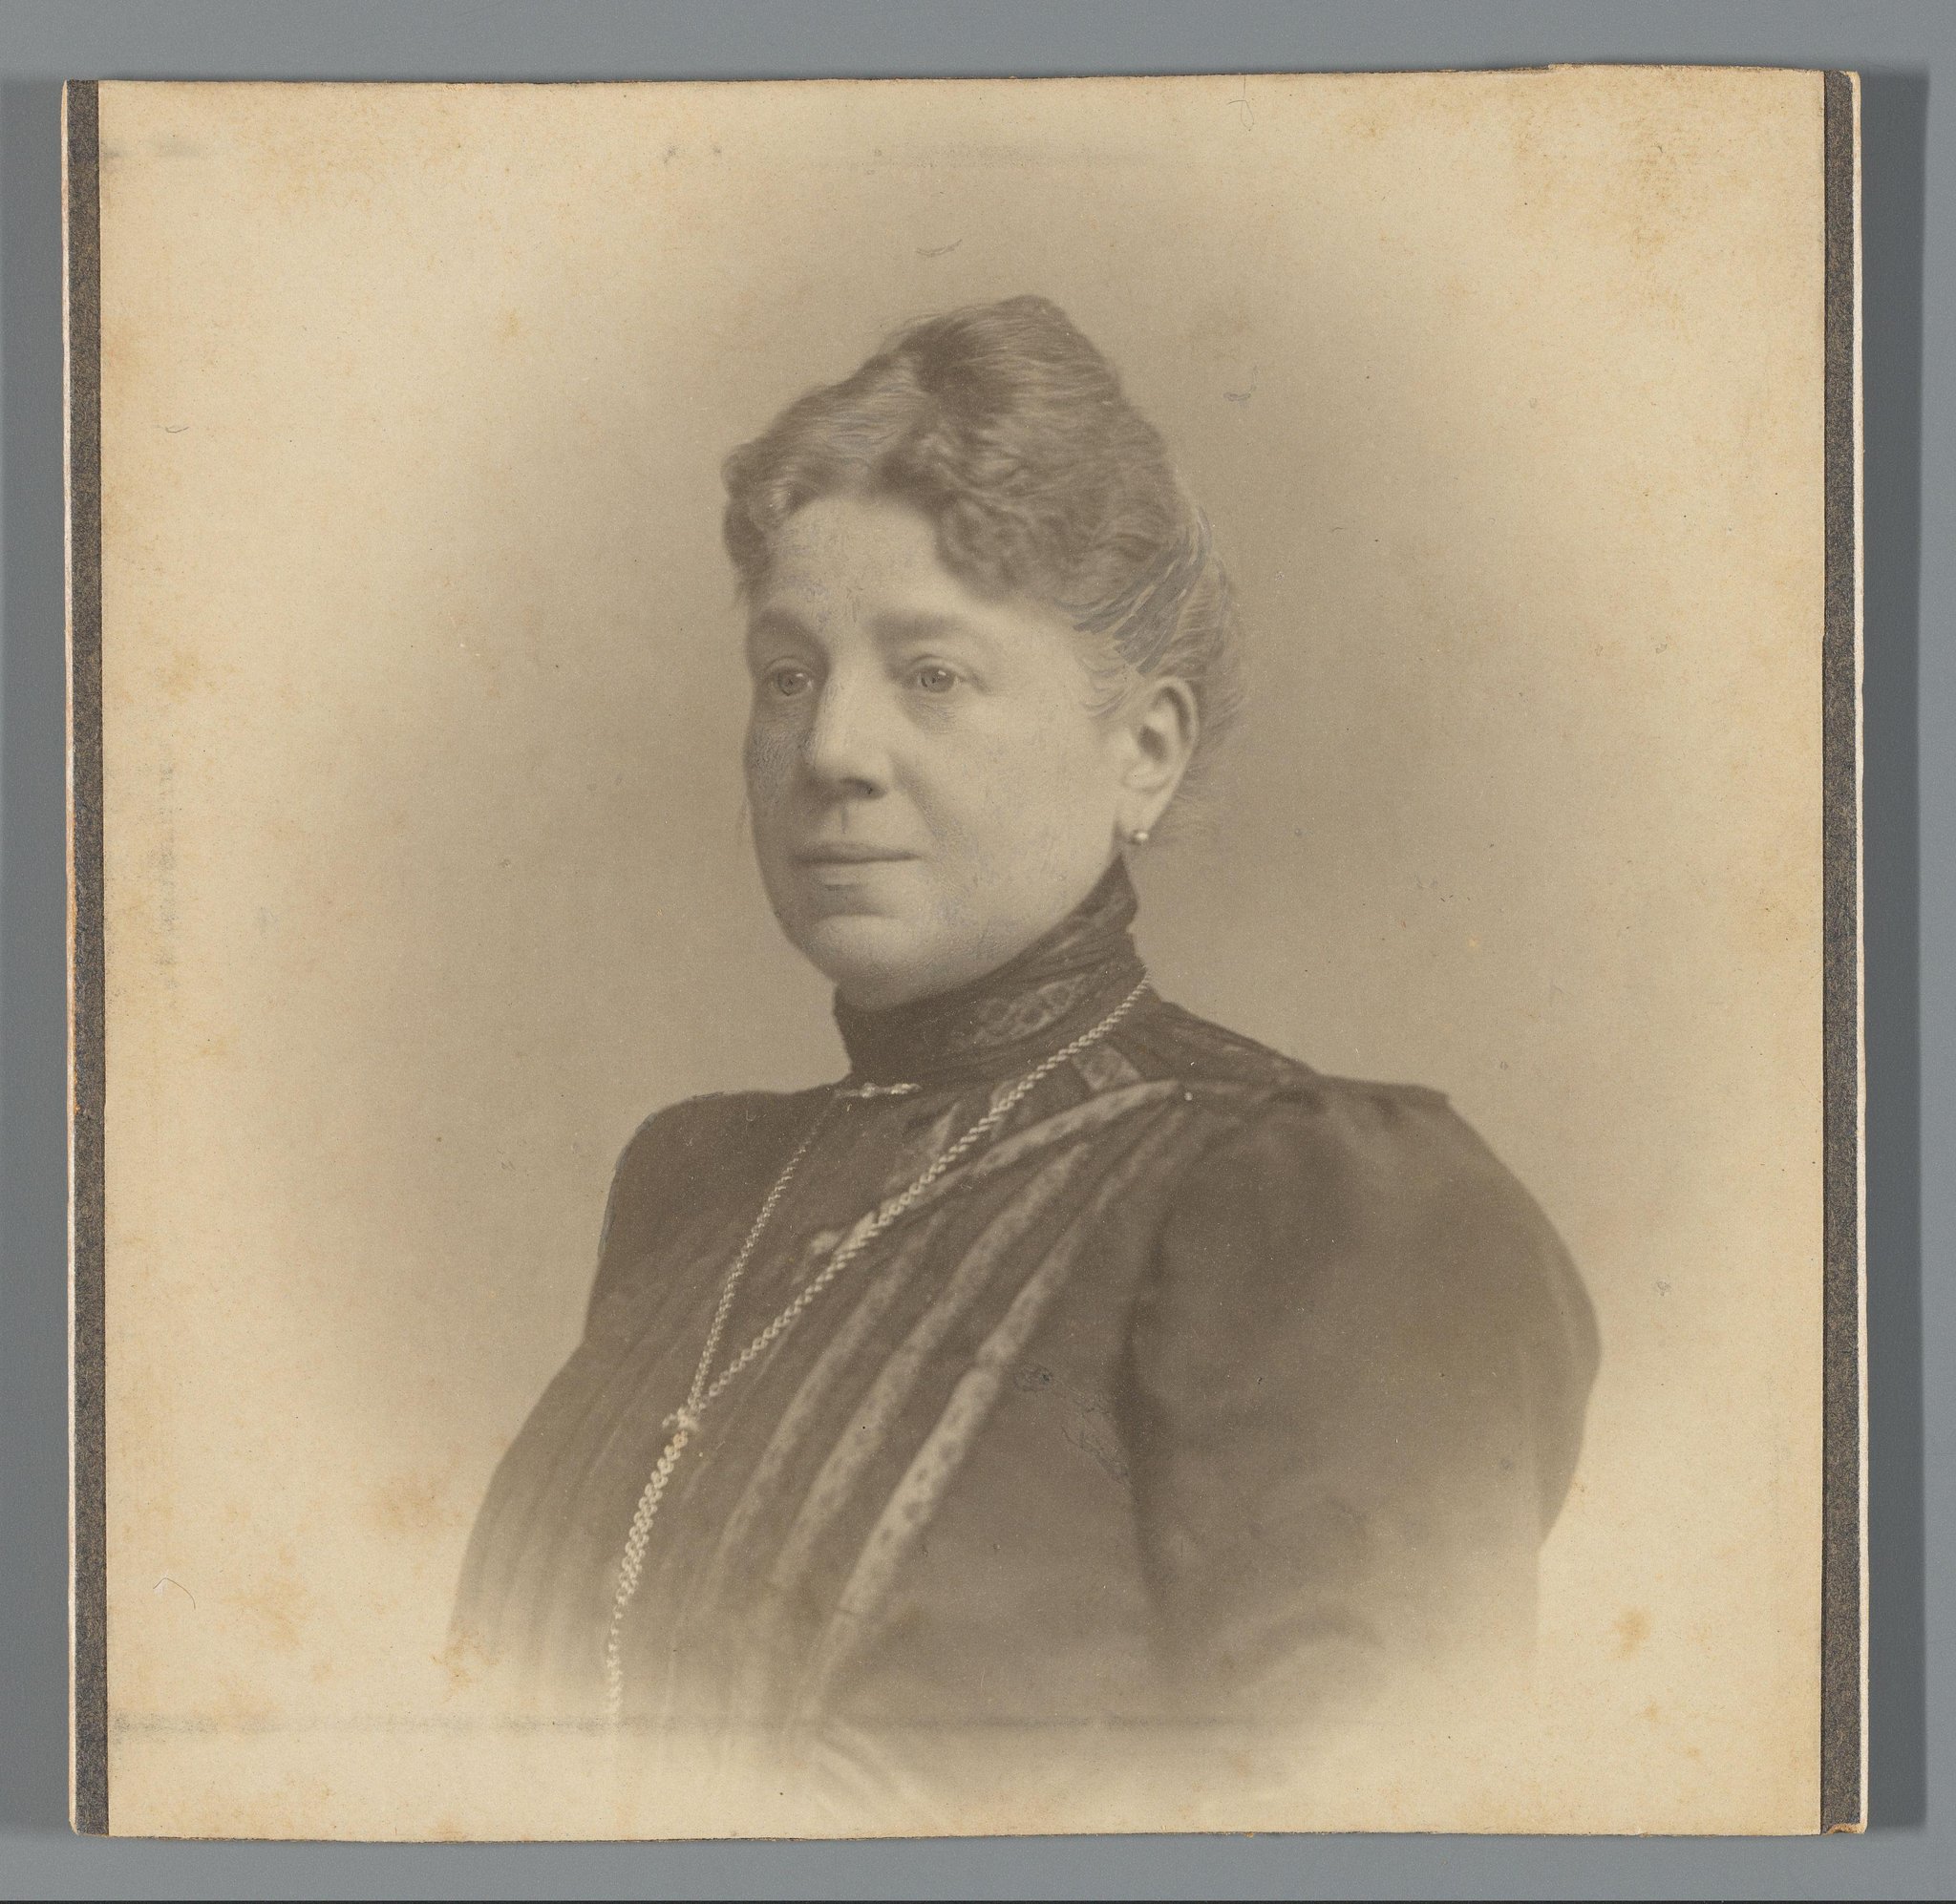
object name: cabinet photograph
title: Portret van Carolina Frederika Holle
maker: franz friedrich (fotograaf)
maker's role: fotograaf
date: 1890-1909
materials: cardboard, photographic support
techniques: albumen print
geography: marienbad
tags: amsterdam, carolina frederika van den berg-holle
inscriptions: name